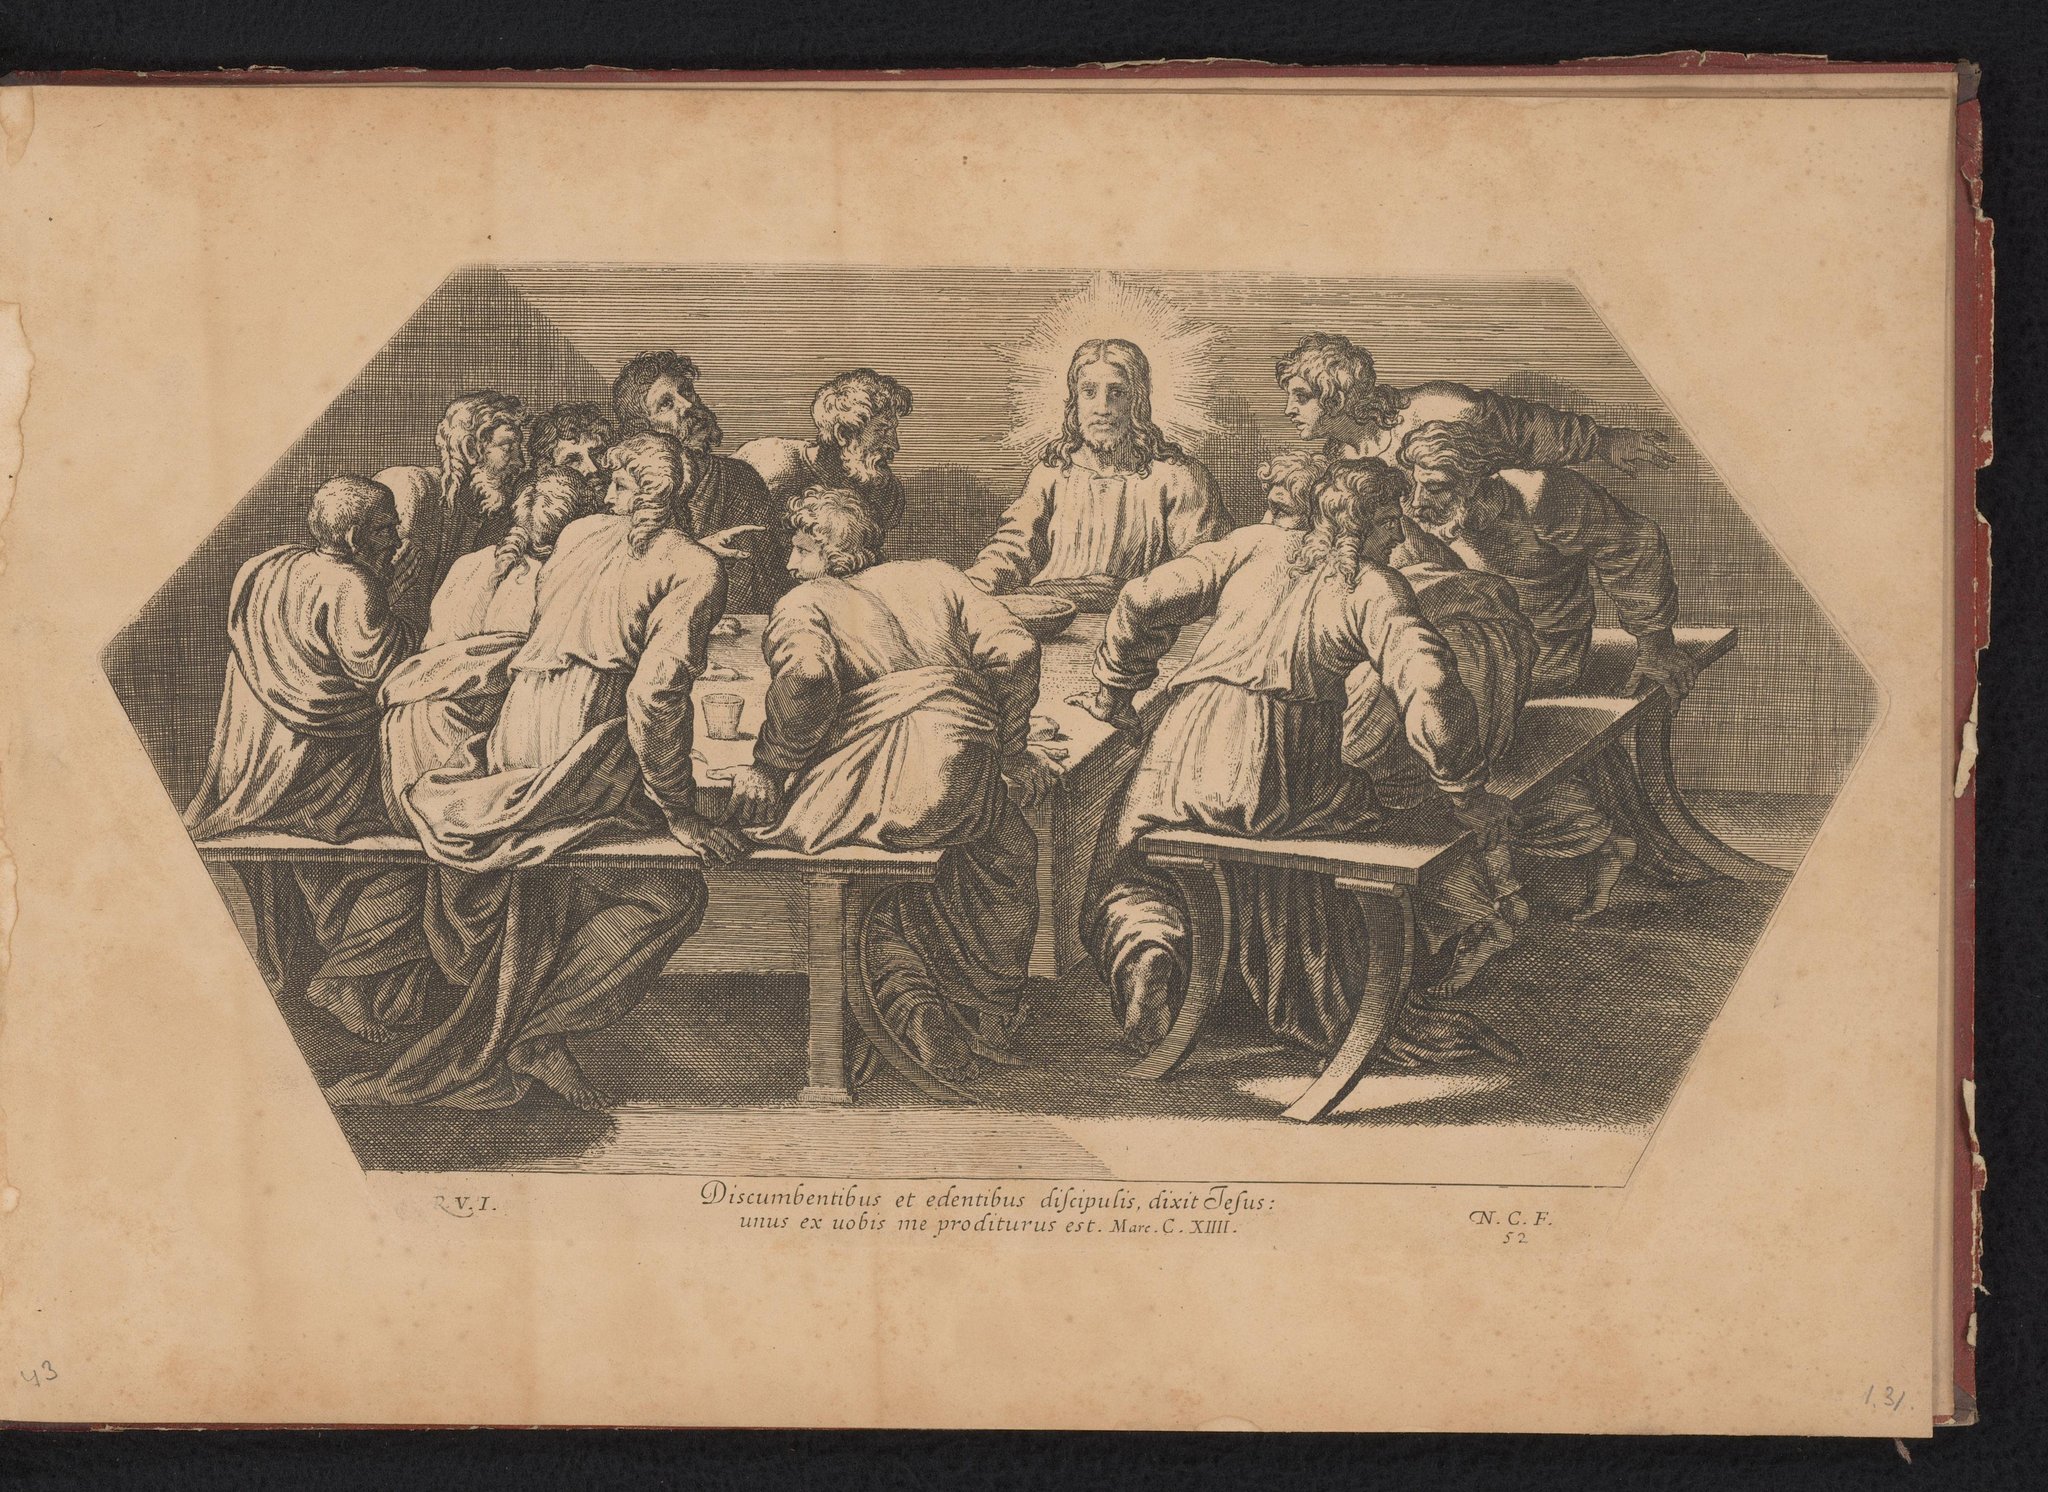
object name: print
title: Laatste Avondmaal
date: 1649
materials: paper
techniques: etching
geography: paris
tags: last supper (in general) (matthew 26:21-35; mark 14:18-31; luke 22:3, 22:15-23; john 13:21-38)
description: Deze prent maakt deel uit van een album.